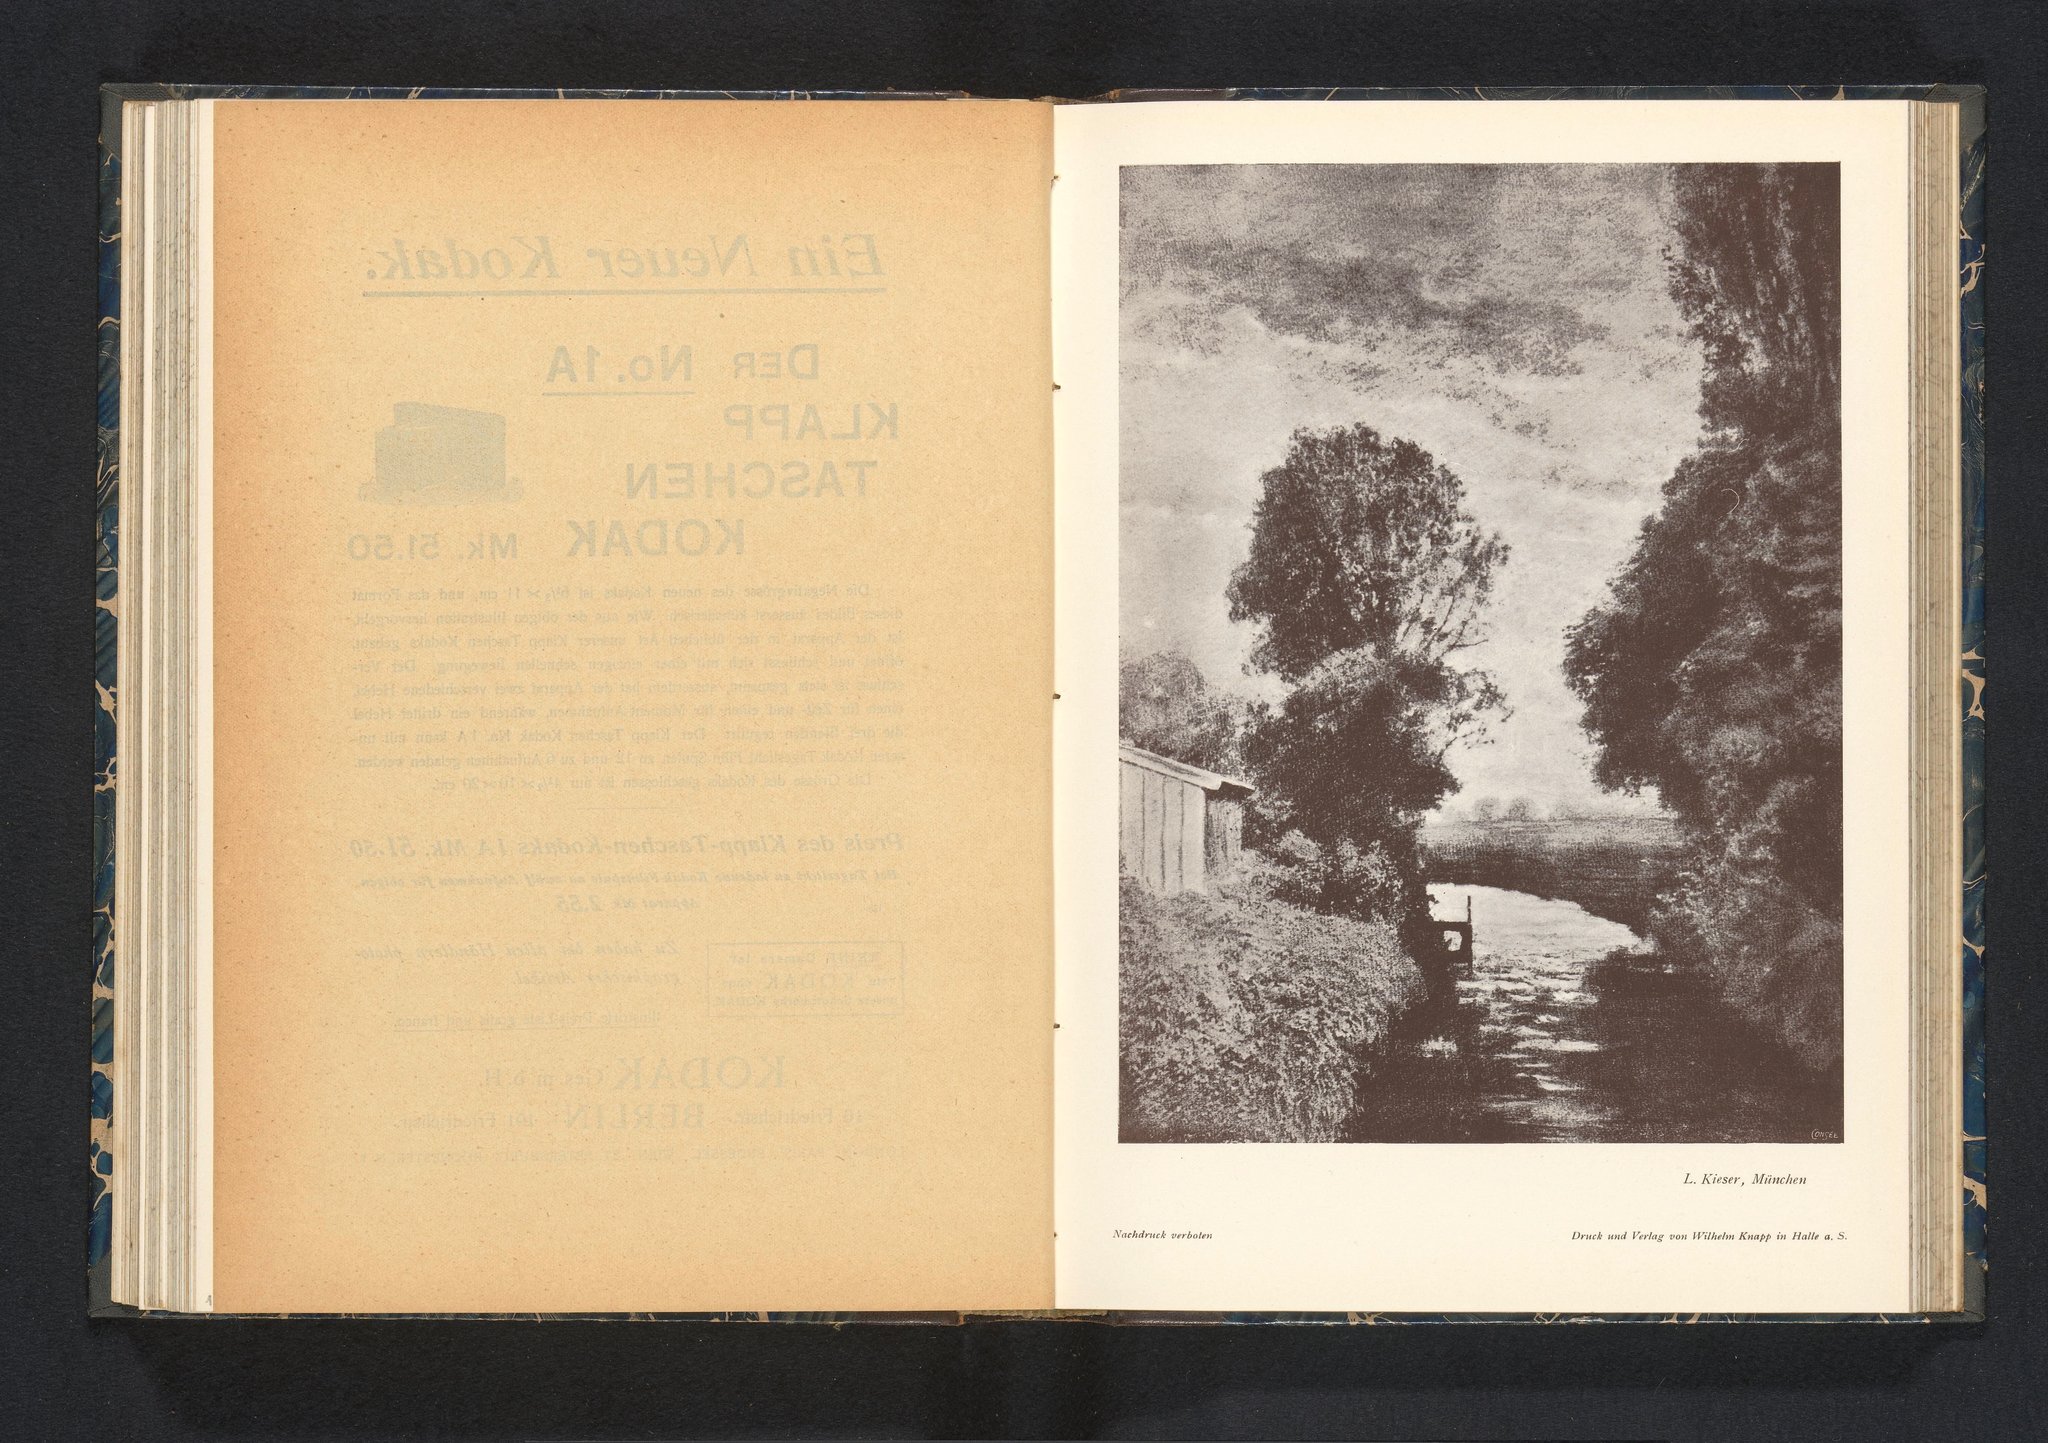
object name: page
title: Reproductie van een schilderij van een landschap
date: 1896-1901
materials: paper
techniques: autotype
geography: halle an der saale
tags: landscapes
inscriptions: monogram: ‘Consée’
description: Prent op vierde ongenummerde pagina na pagina 196.